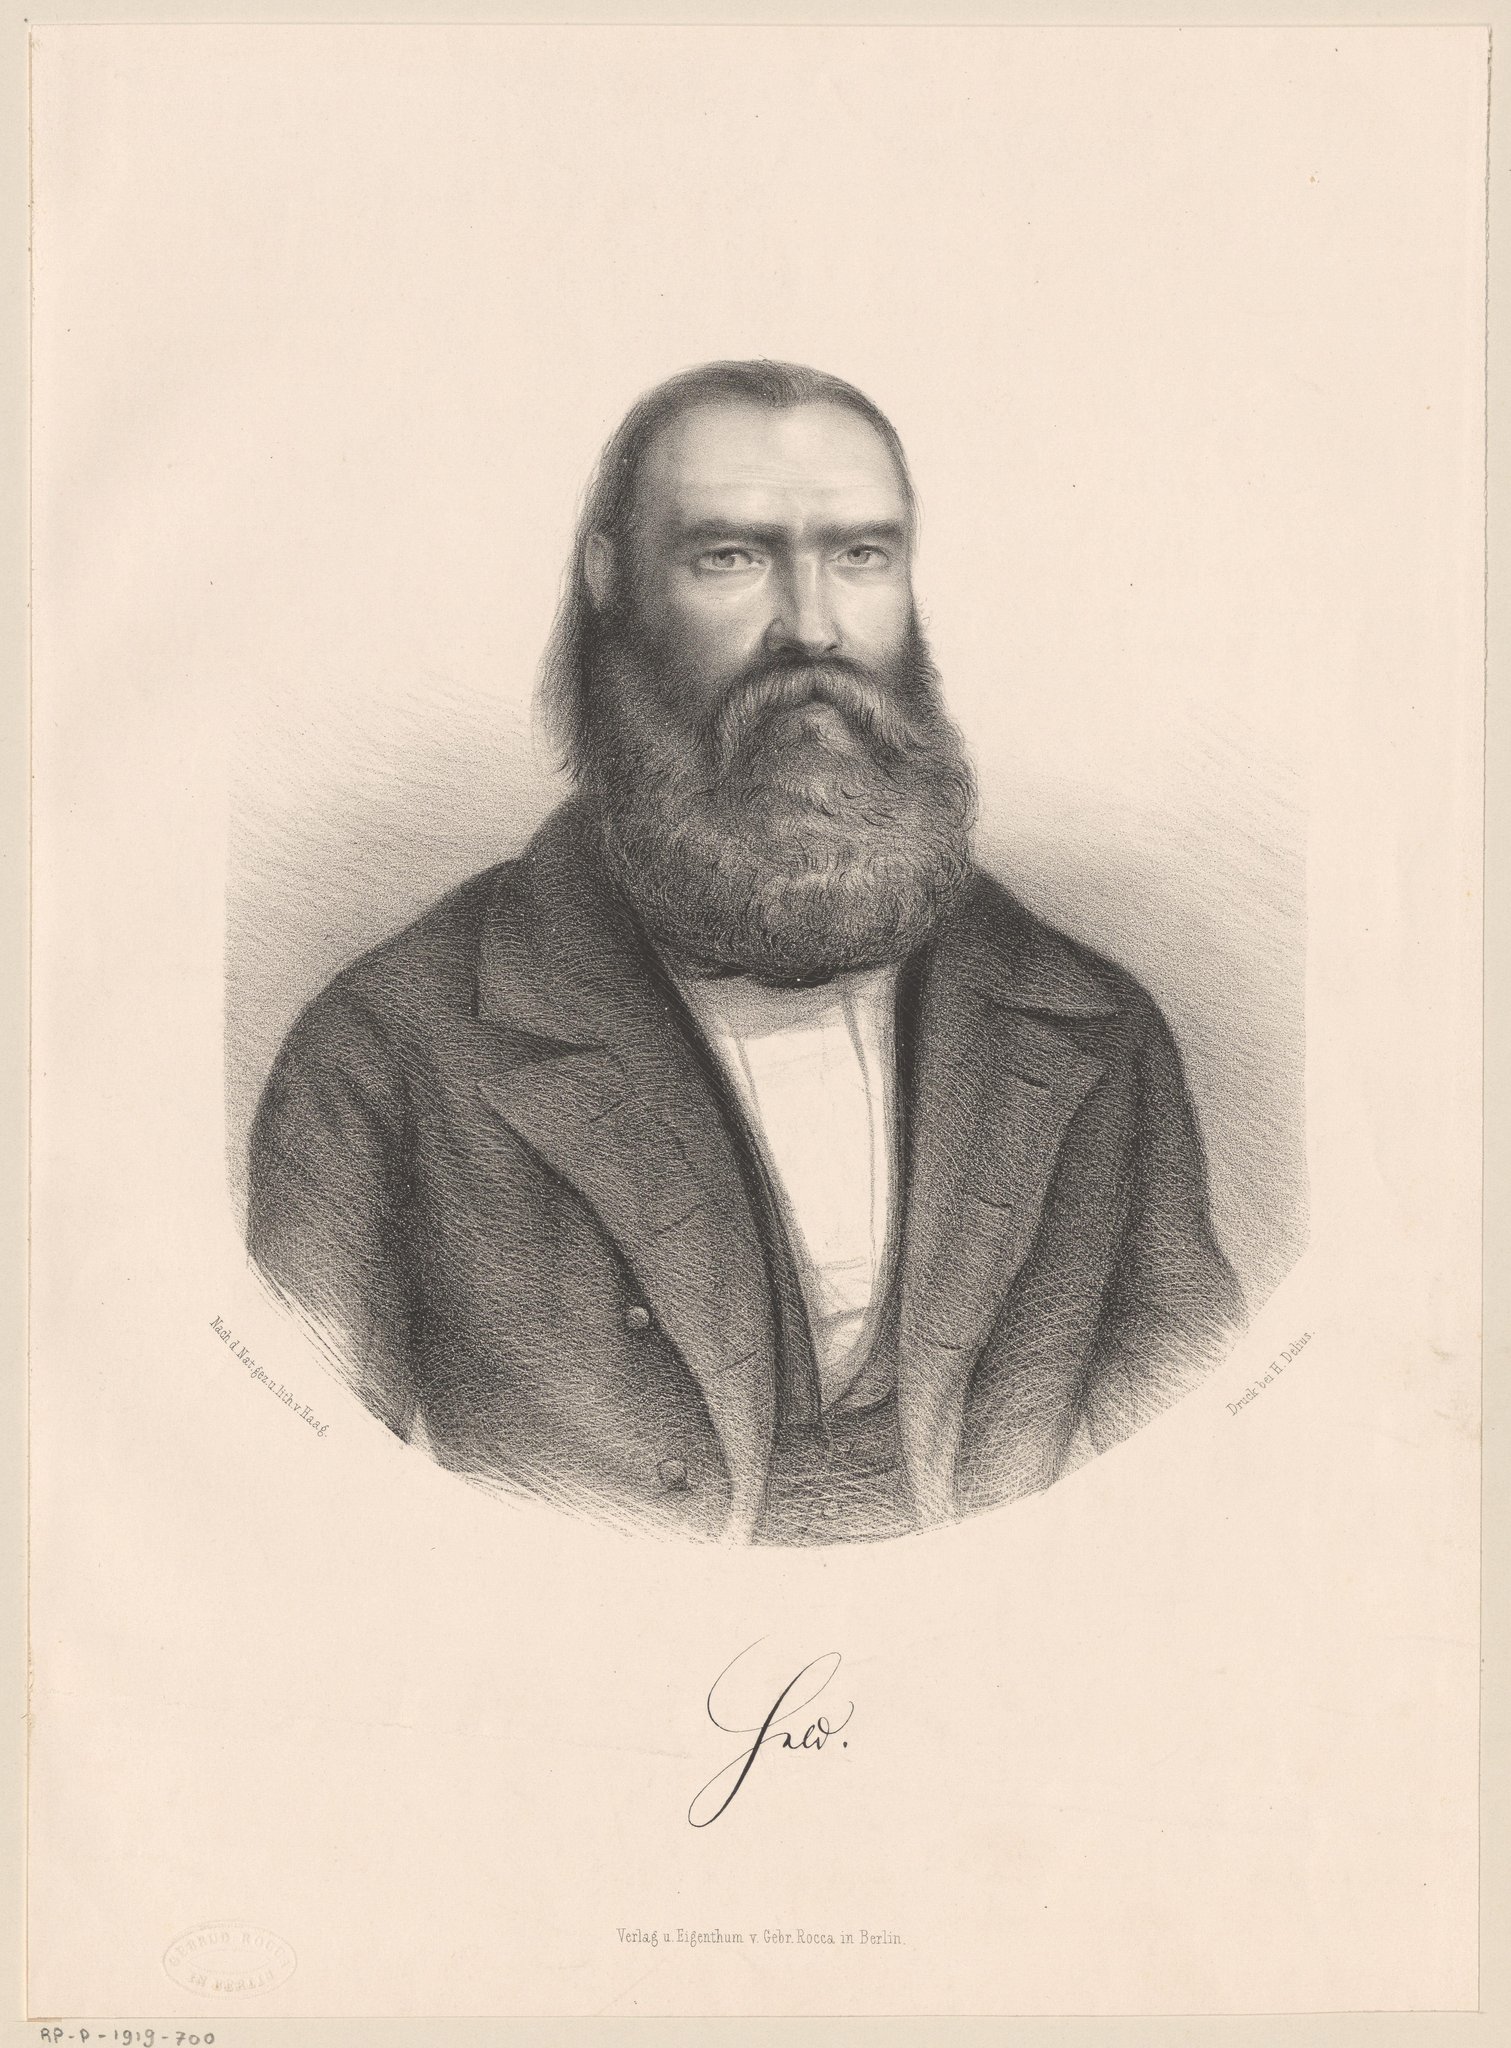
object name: print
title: Portret van een man, aangeduid als Held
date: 1842-1860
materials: paper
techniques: lithograph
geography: berlin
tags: historical persons not known by name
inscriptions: collector's mark: Lugt 2228, workshop stamp: Lugt 2141c